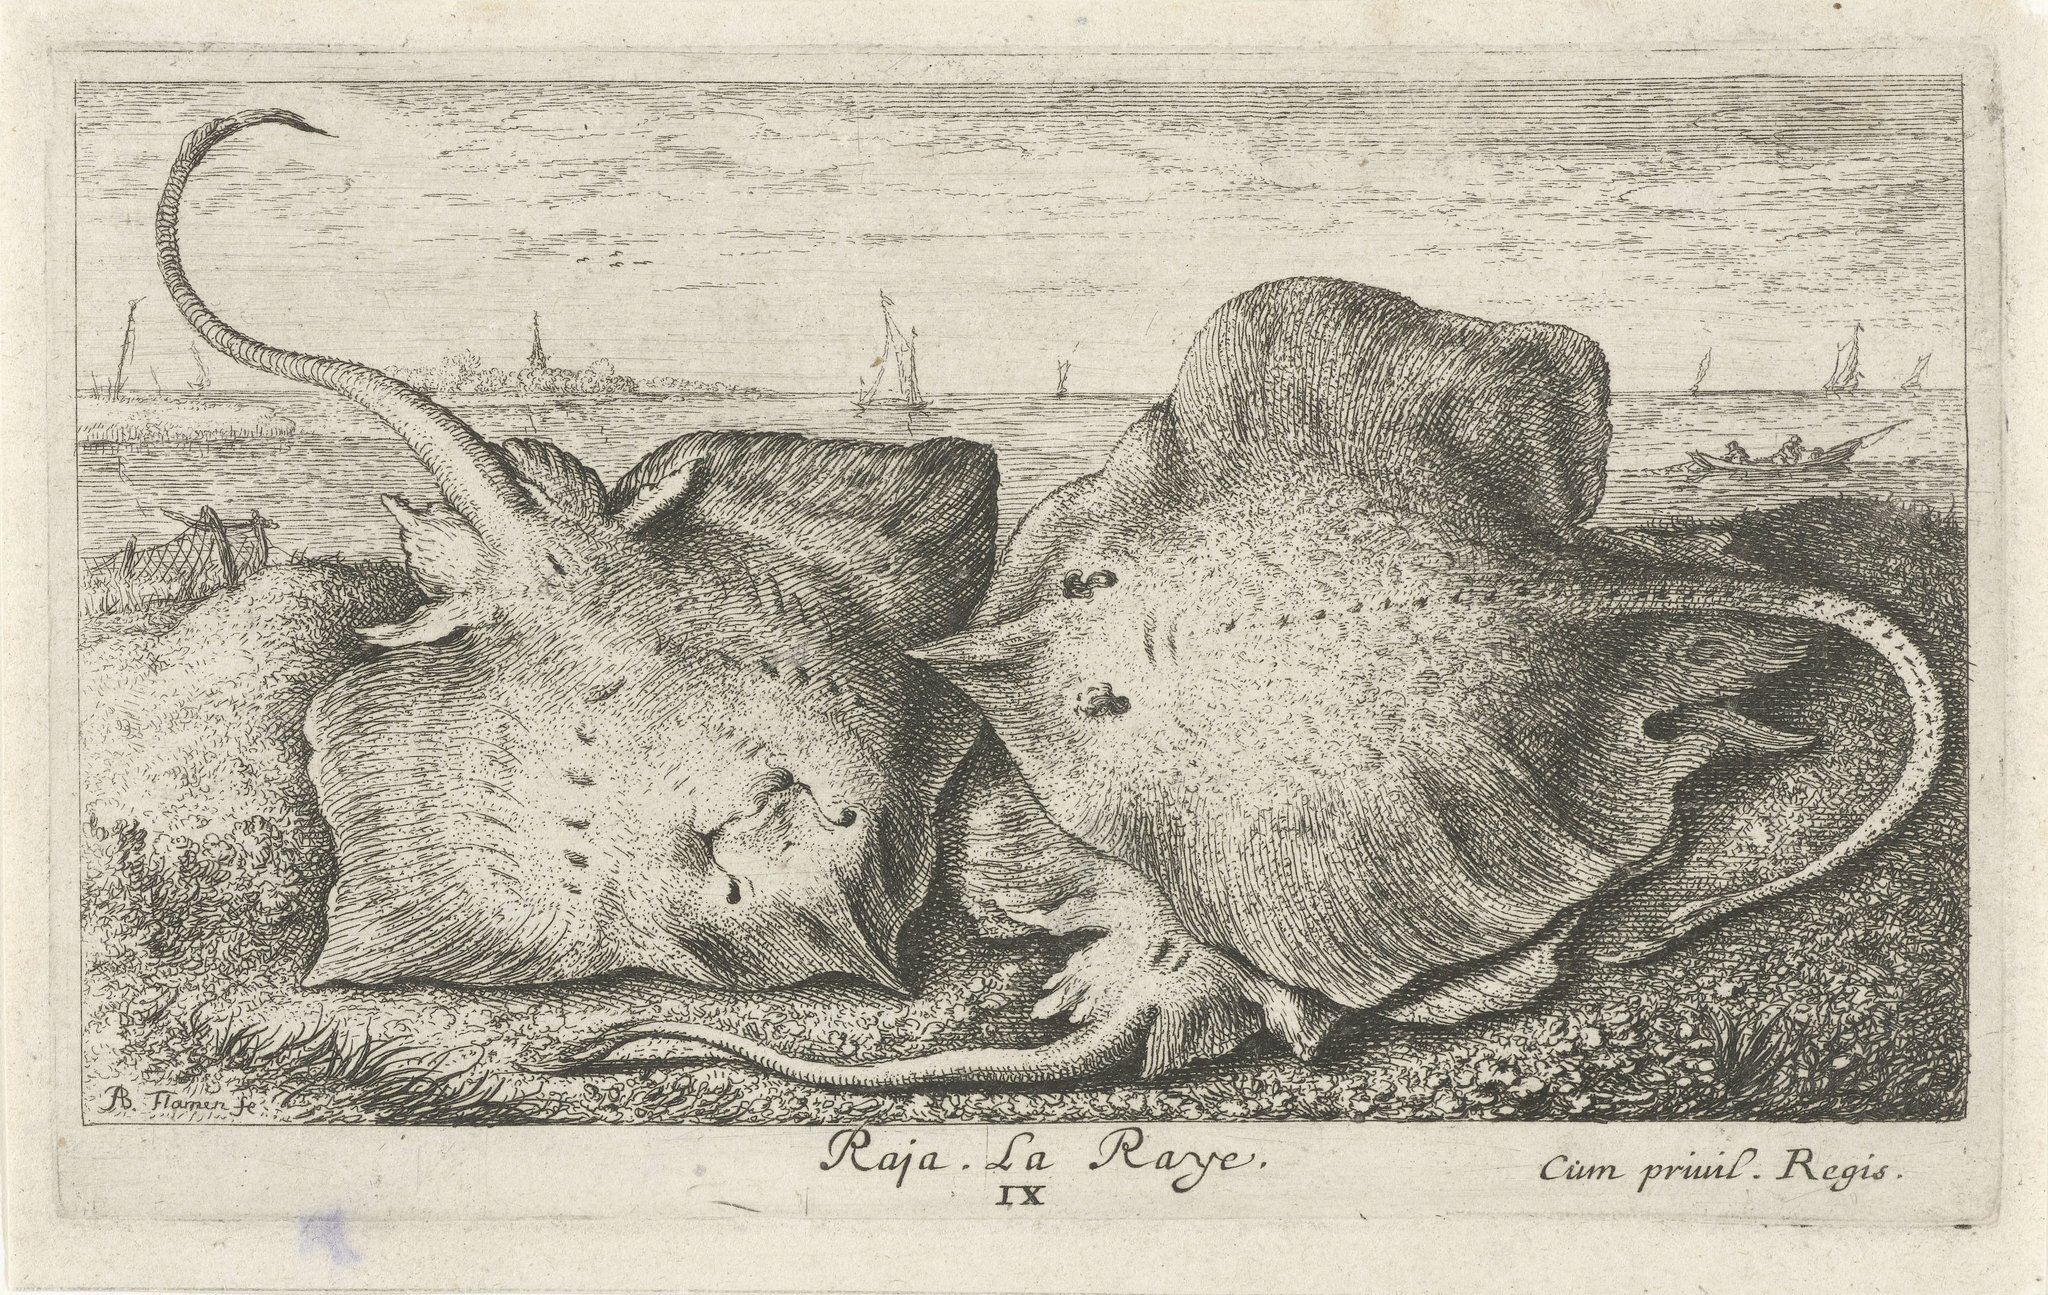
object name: print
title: Drie roggen op het strand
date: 1664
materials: paper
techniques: etching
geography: paris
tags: cartilaginous fishes: ray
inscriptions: collector's mark: Lugt 2228, collector's mark: Lugt 1490